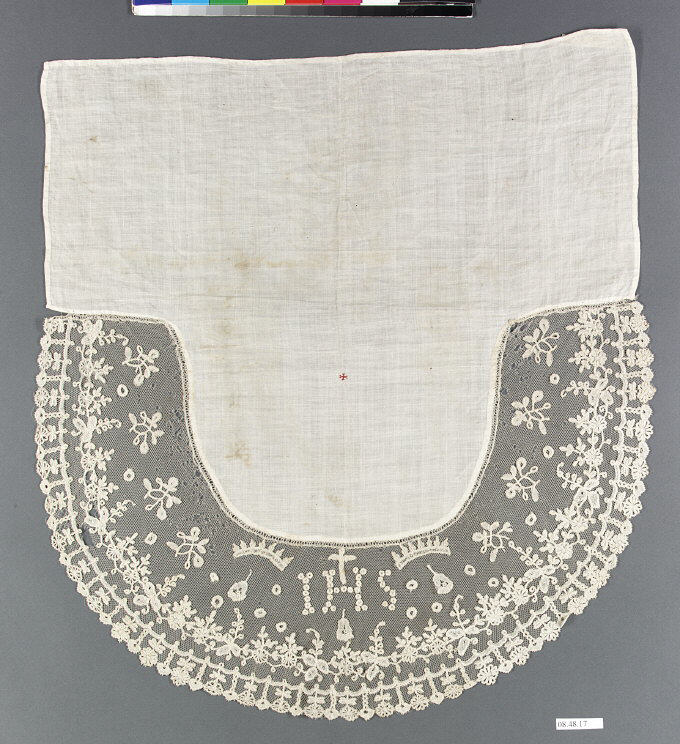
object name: piece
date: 1834-1866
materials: cotton, linen